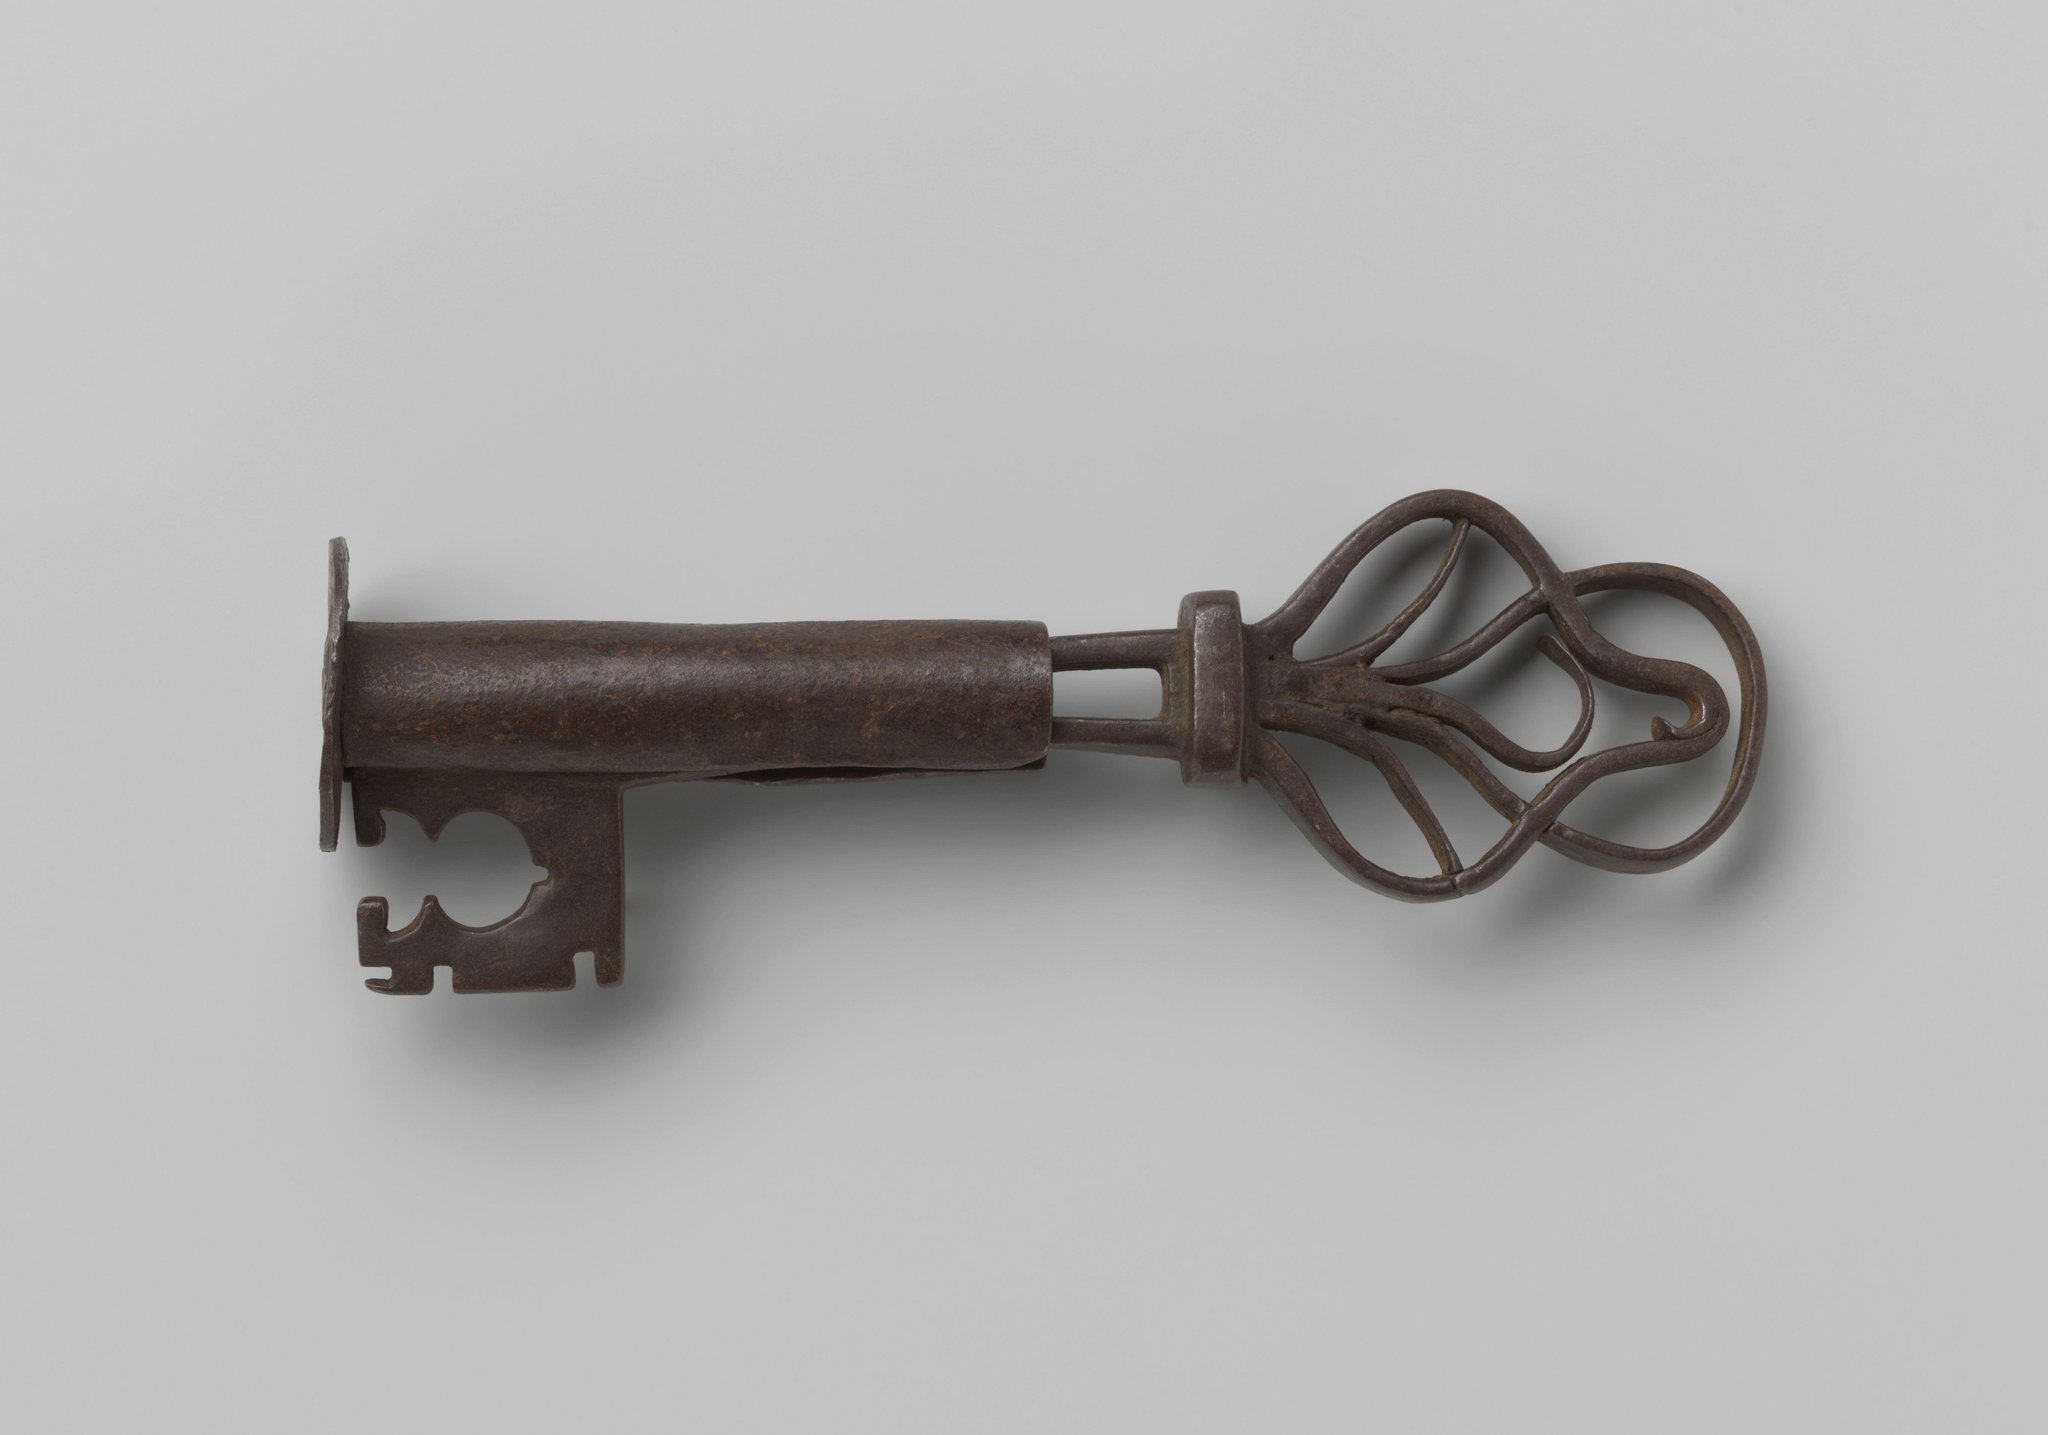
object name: key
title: Sleutel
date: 1400-1950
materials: iron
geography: spain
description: Sleutel met bijbehorende vormbus. De greep bestaat uit een palmet, de steel is overlangs gespleten en de baard heeft een moskee-achtige uitsnijding.